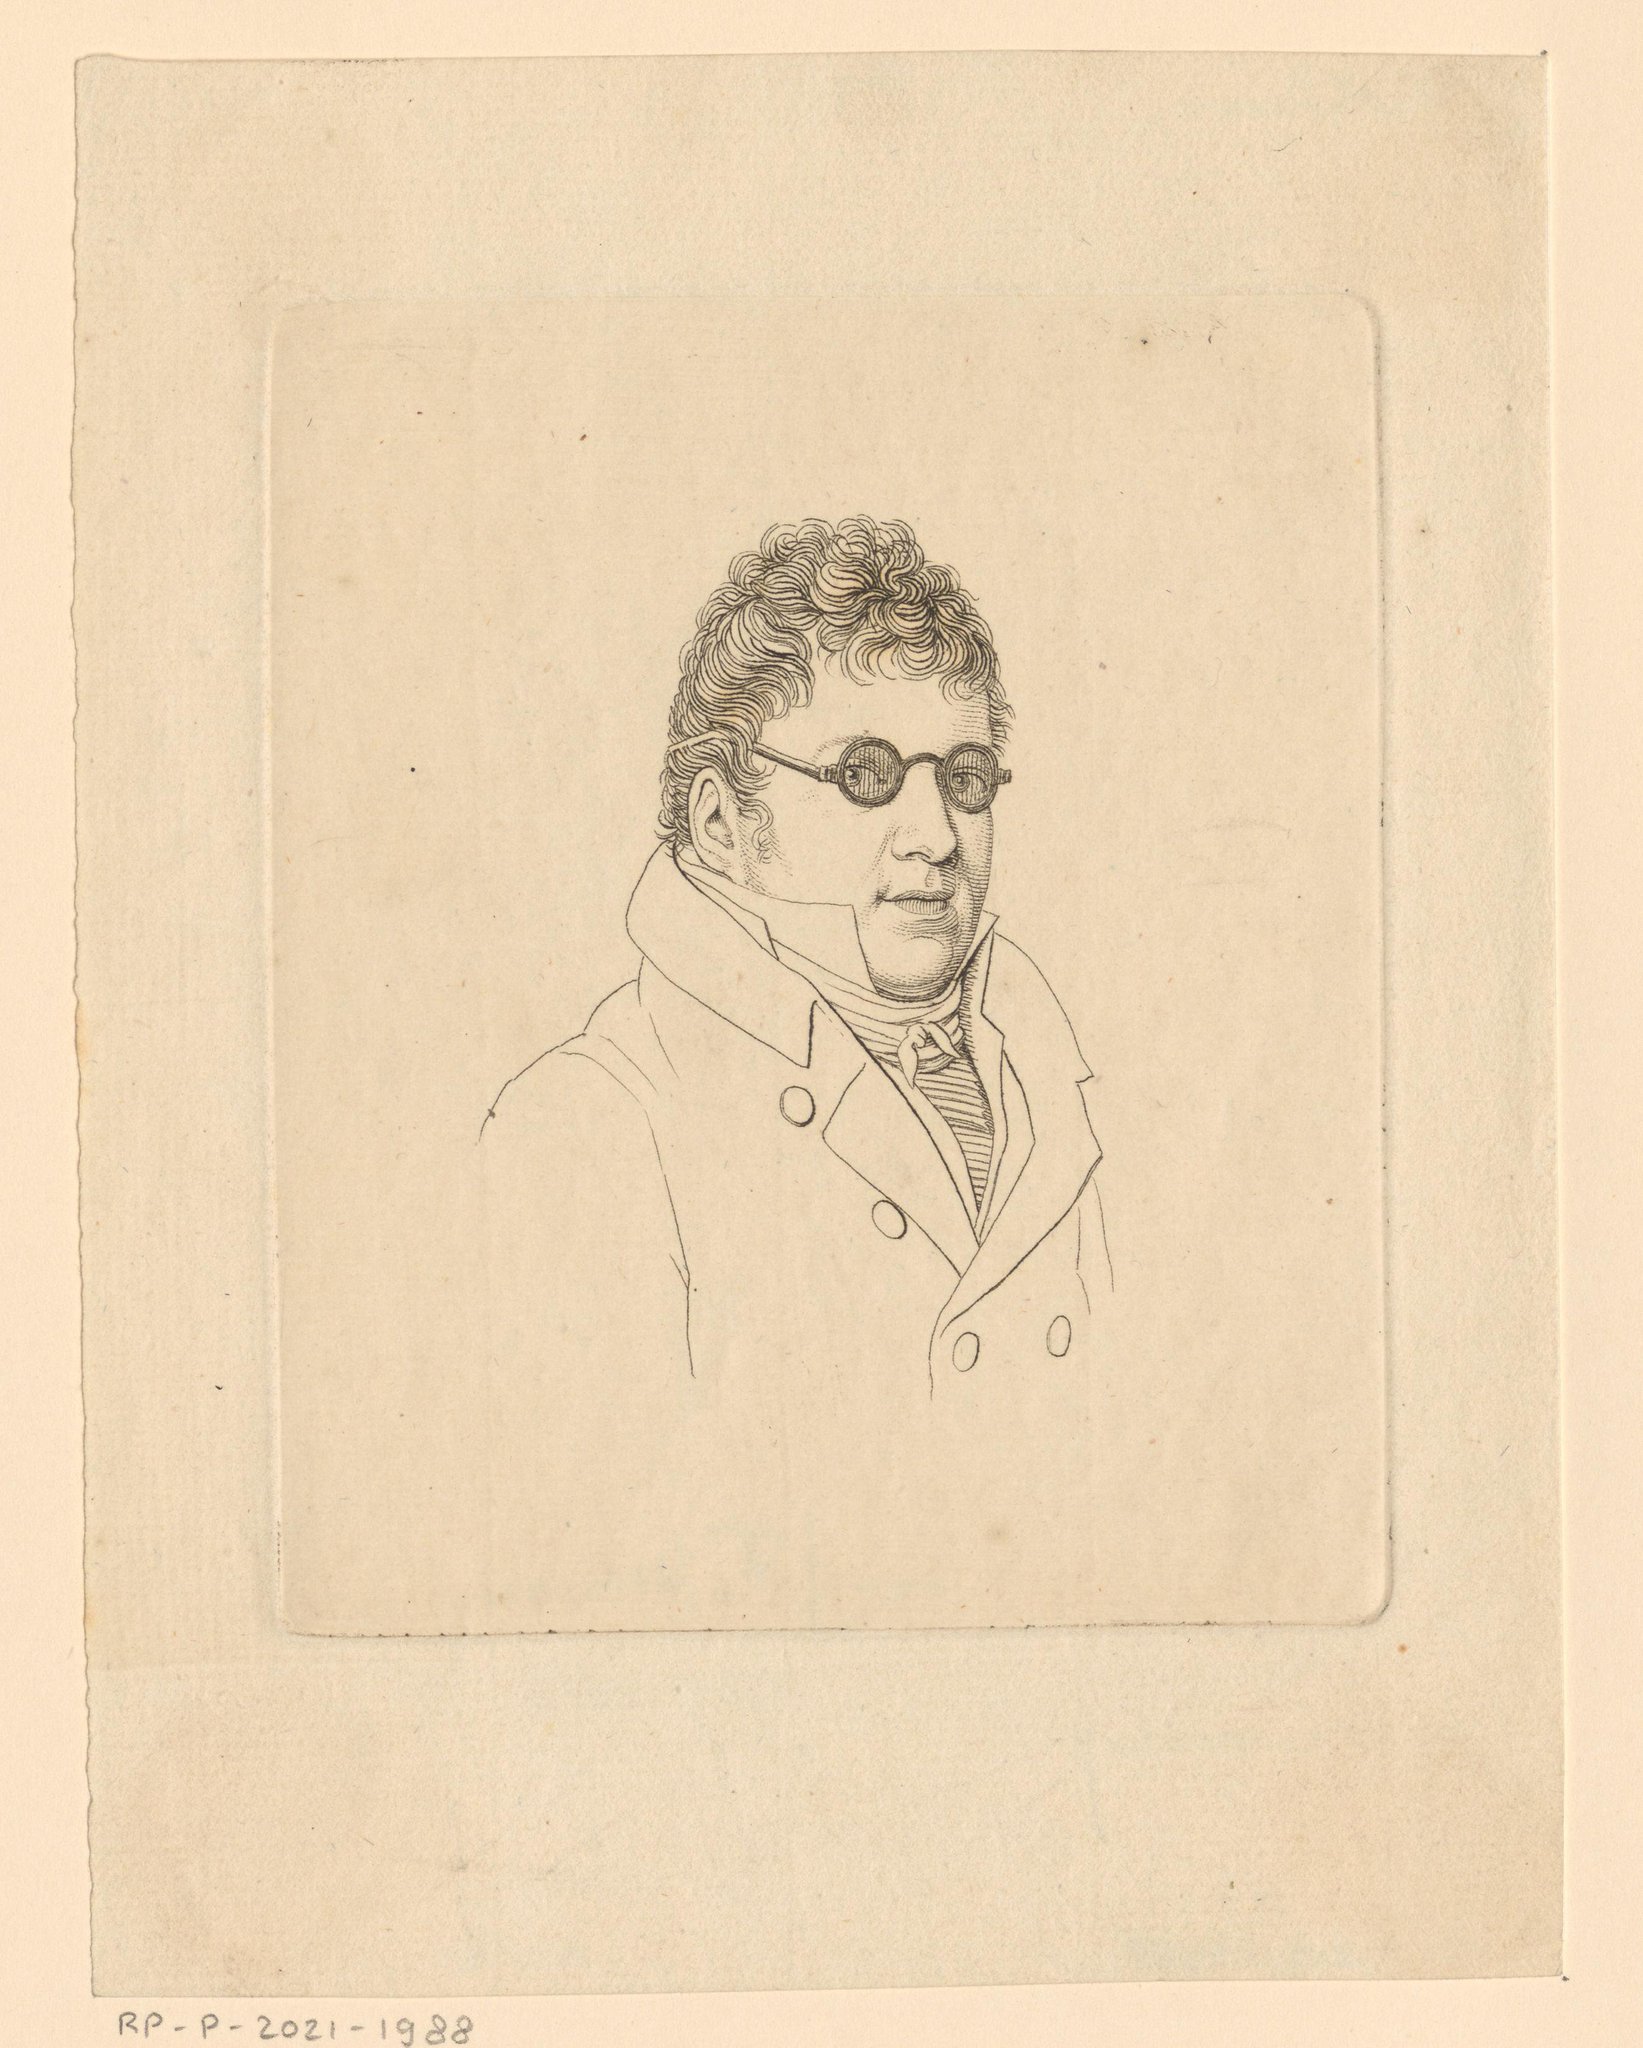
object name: print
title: Portret van Jan Frederik Helmers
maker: Anonymous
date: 1800-1824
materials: paper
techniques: etching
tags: amsterdam, jan frederik helmers, eyeglasses, spectacles, historical persons, portrait of a writer